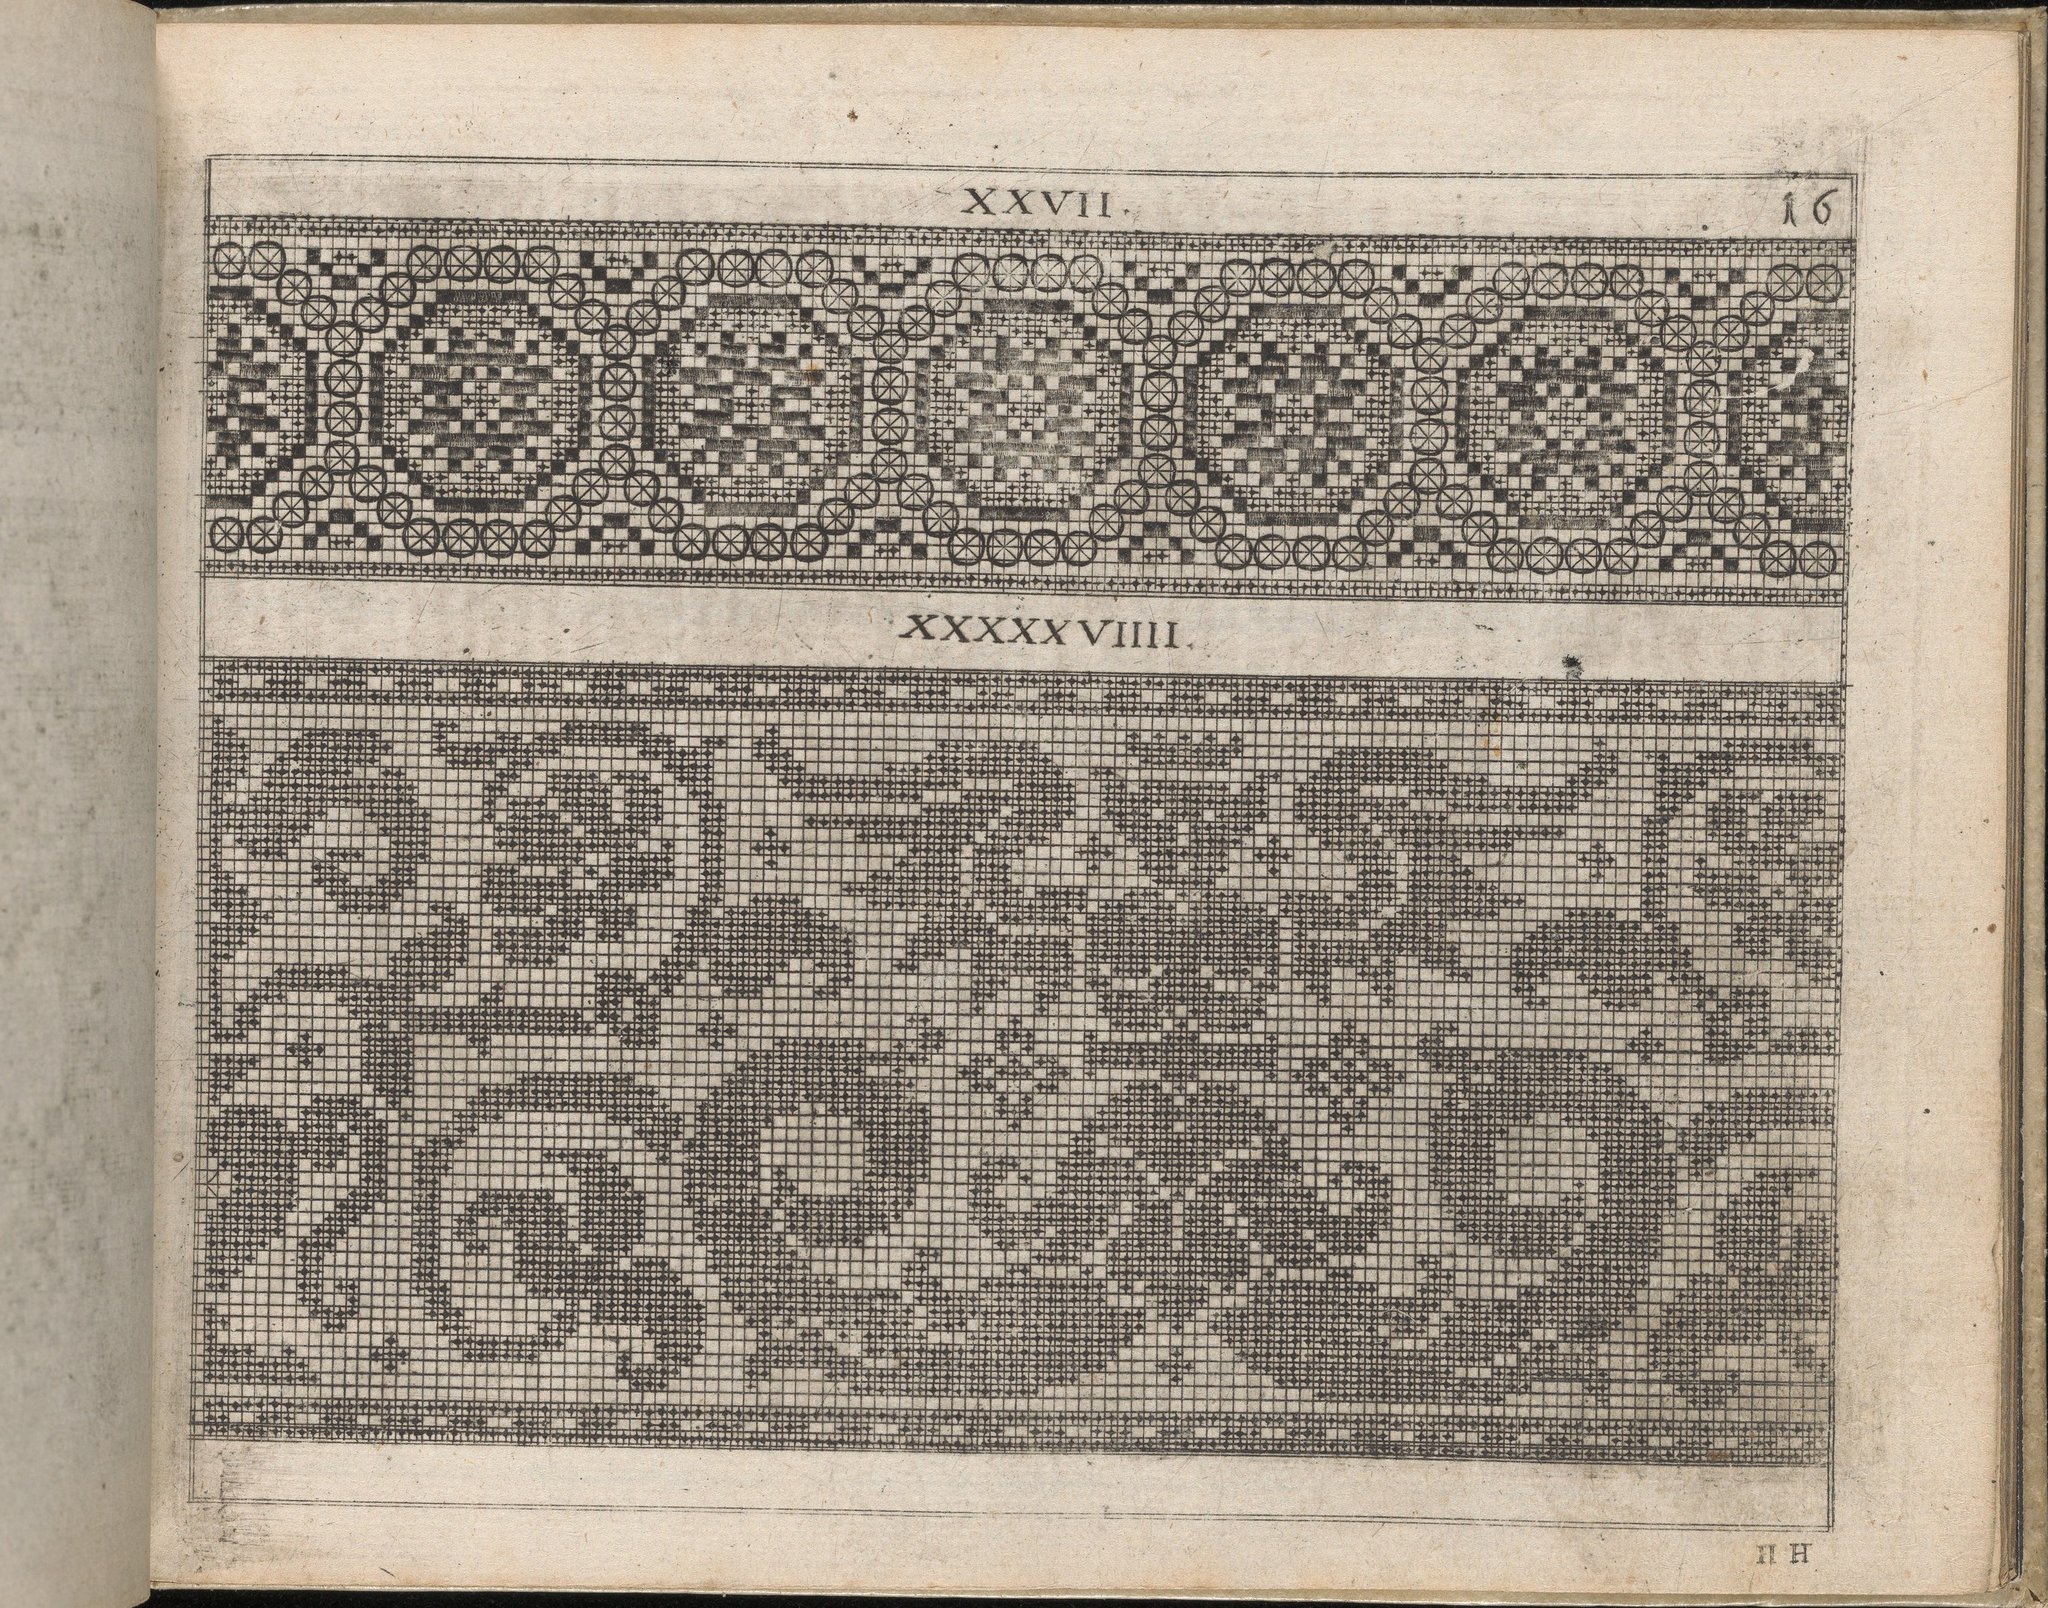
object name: book print ornament architecture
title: Newes Modelbuch in Kupffer (Page 25r)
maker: johann sibmacher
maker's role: artist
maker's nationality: german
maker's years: 1590-1611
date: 1604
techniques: etching